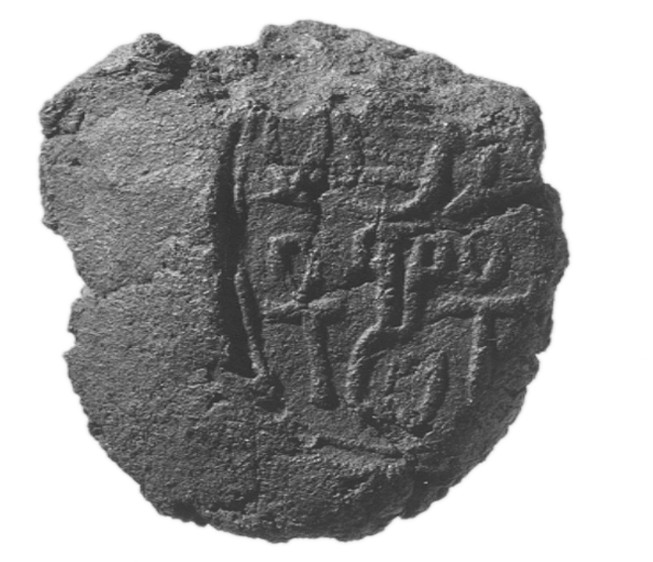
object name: sealing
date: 2030-1640 BCE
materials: clay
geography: egypt